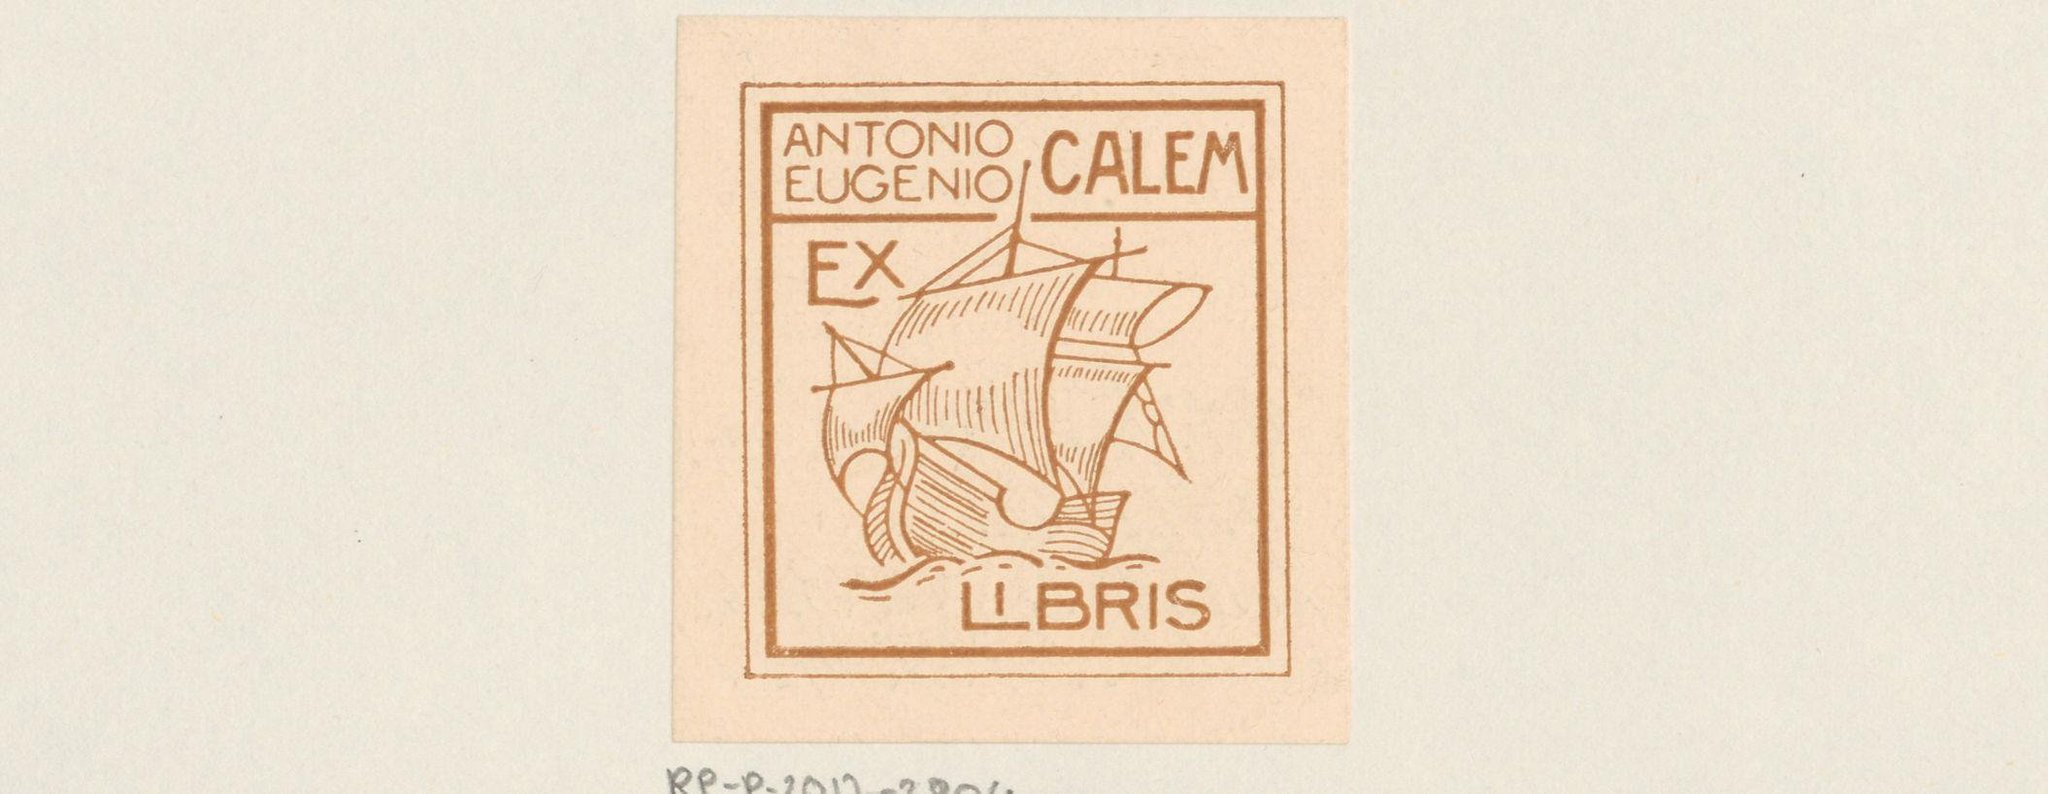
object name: bookplate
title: Ex libris van Antonio Eugenio Calem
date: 1924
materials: paper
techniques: printing block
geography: portugal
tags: sailing-ship, sailing-boat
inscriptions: inscription: ‘Anto. José Ramos (?) P[...]i (?) / [...] / desenho (?) di José Rozas / [...] Porto 1924’